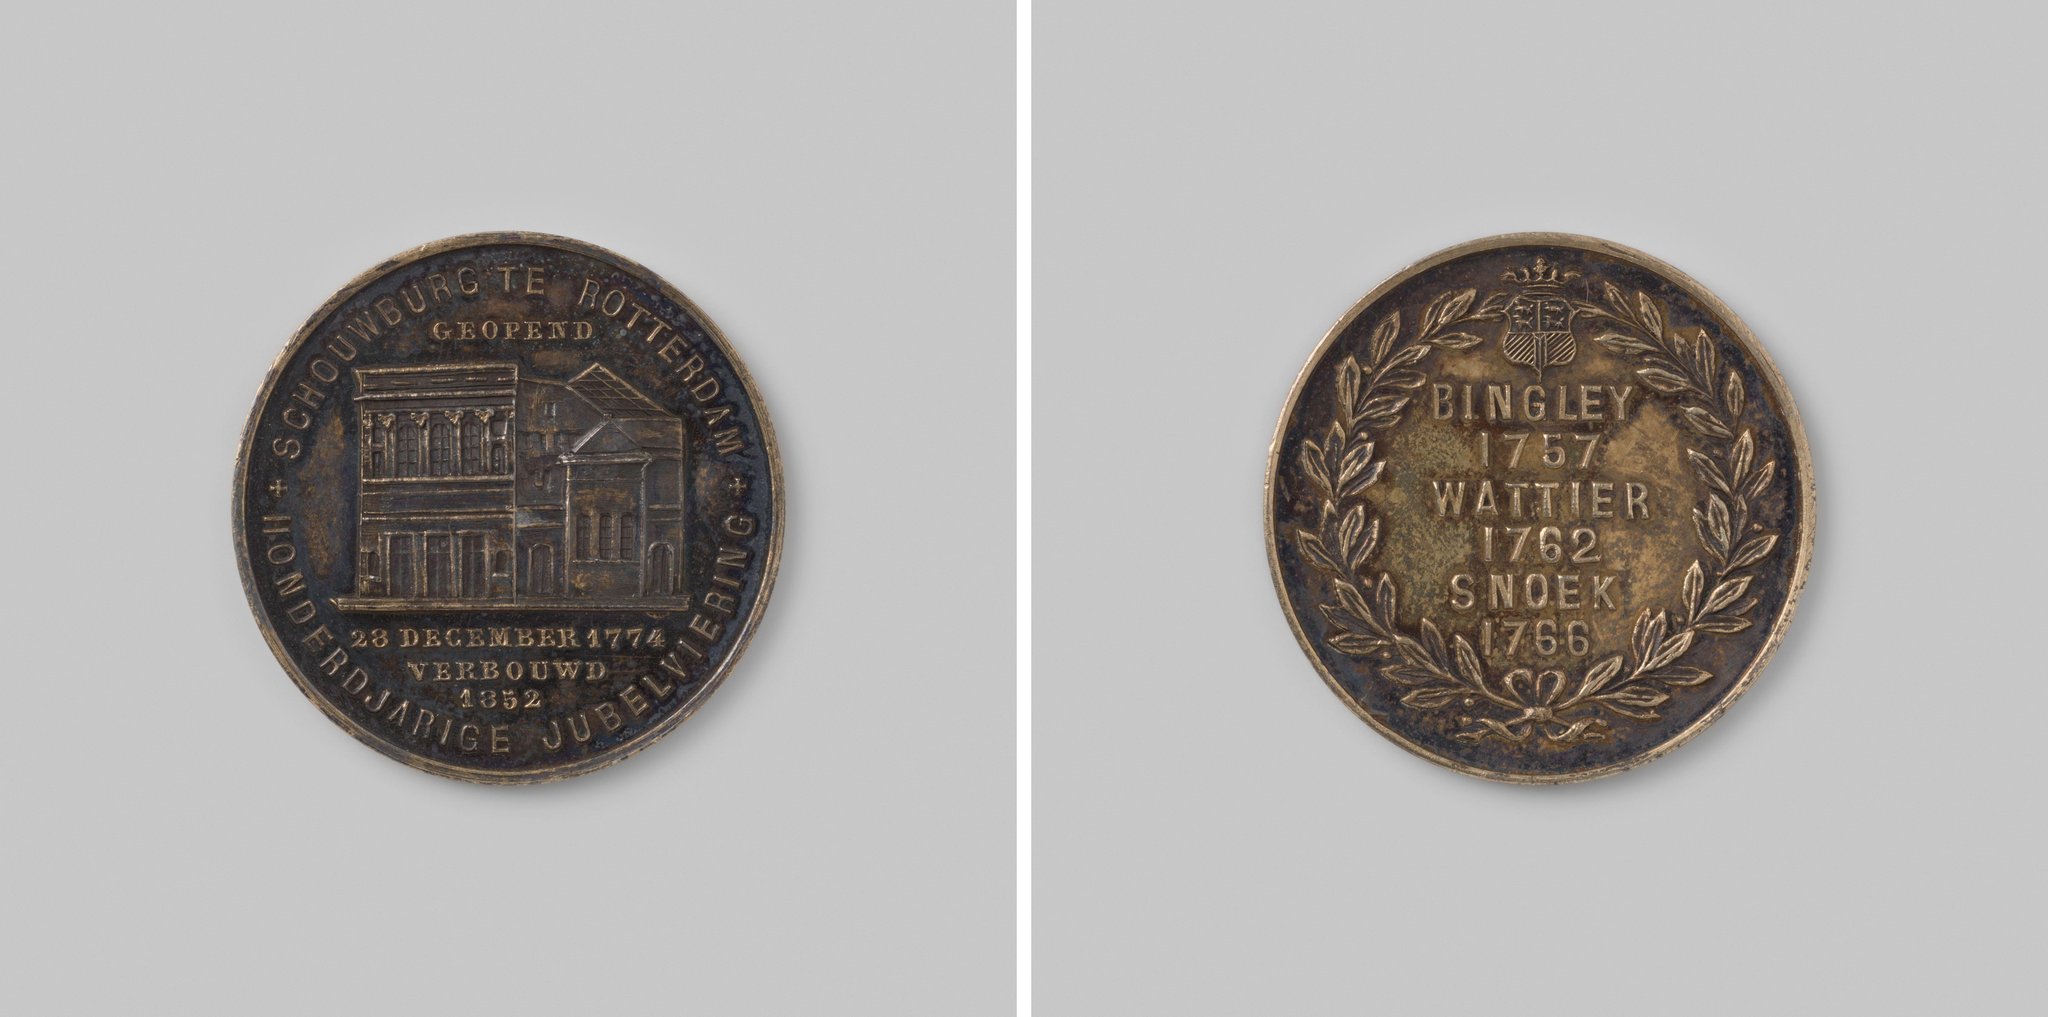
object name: history medal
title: Honderdjarig bestaan van de schouwburg te Rotterdam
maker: Anonymous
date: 1852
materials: metal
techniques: gilding, striking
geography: netherlands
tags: rotterdam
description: Voorzijde: schouwburg binnen omschrift; afsnede: opschrift. Keerzijde: opschrift onder gekroond wapenschild binnen lauwerkrans